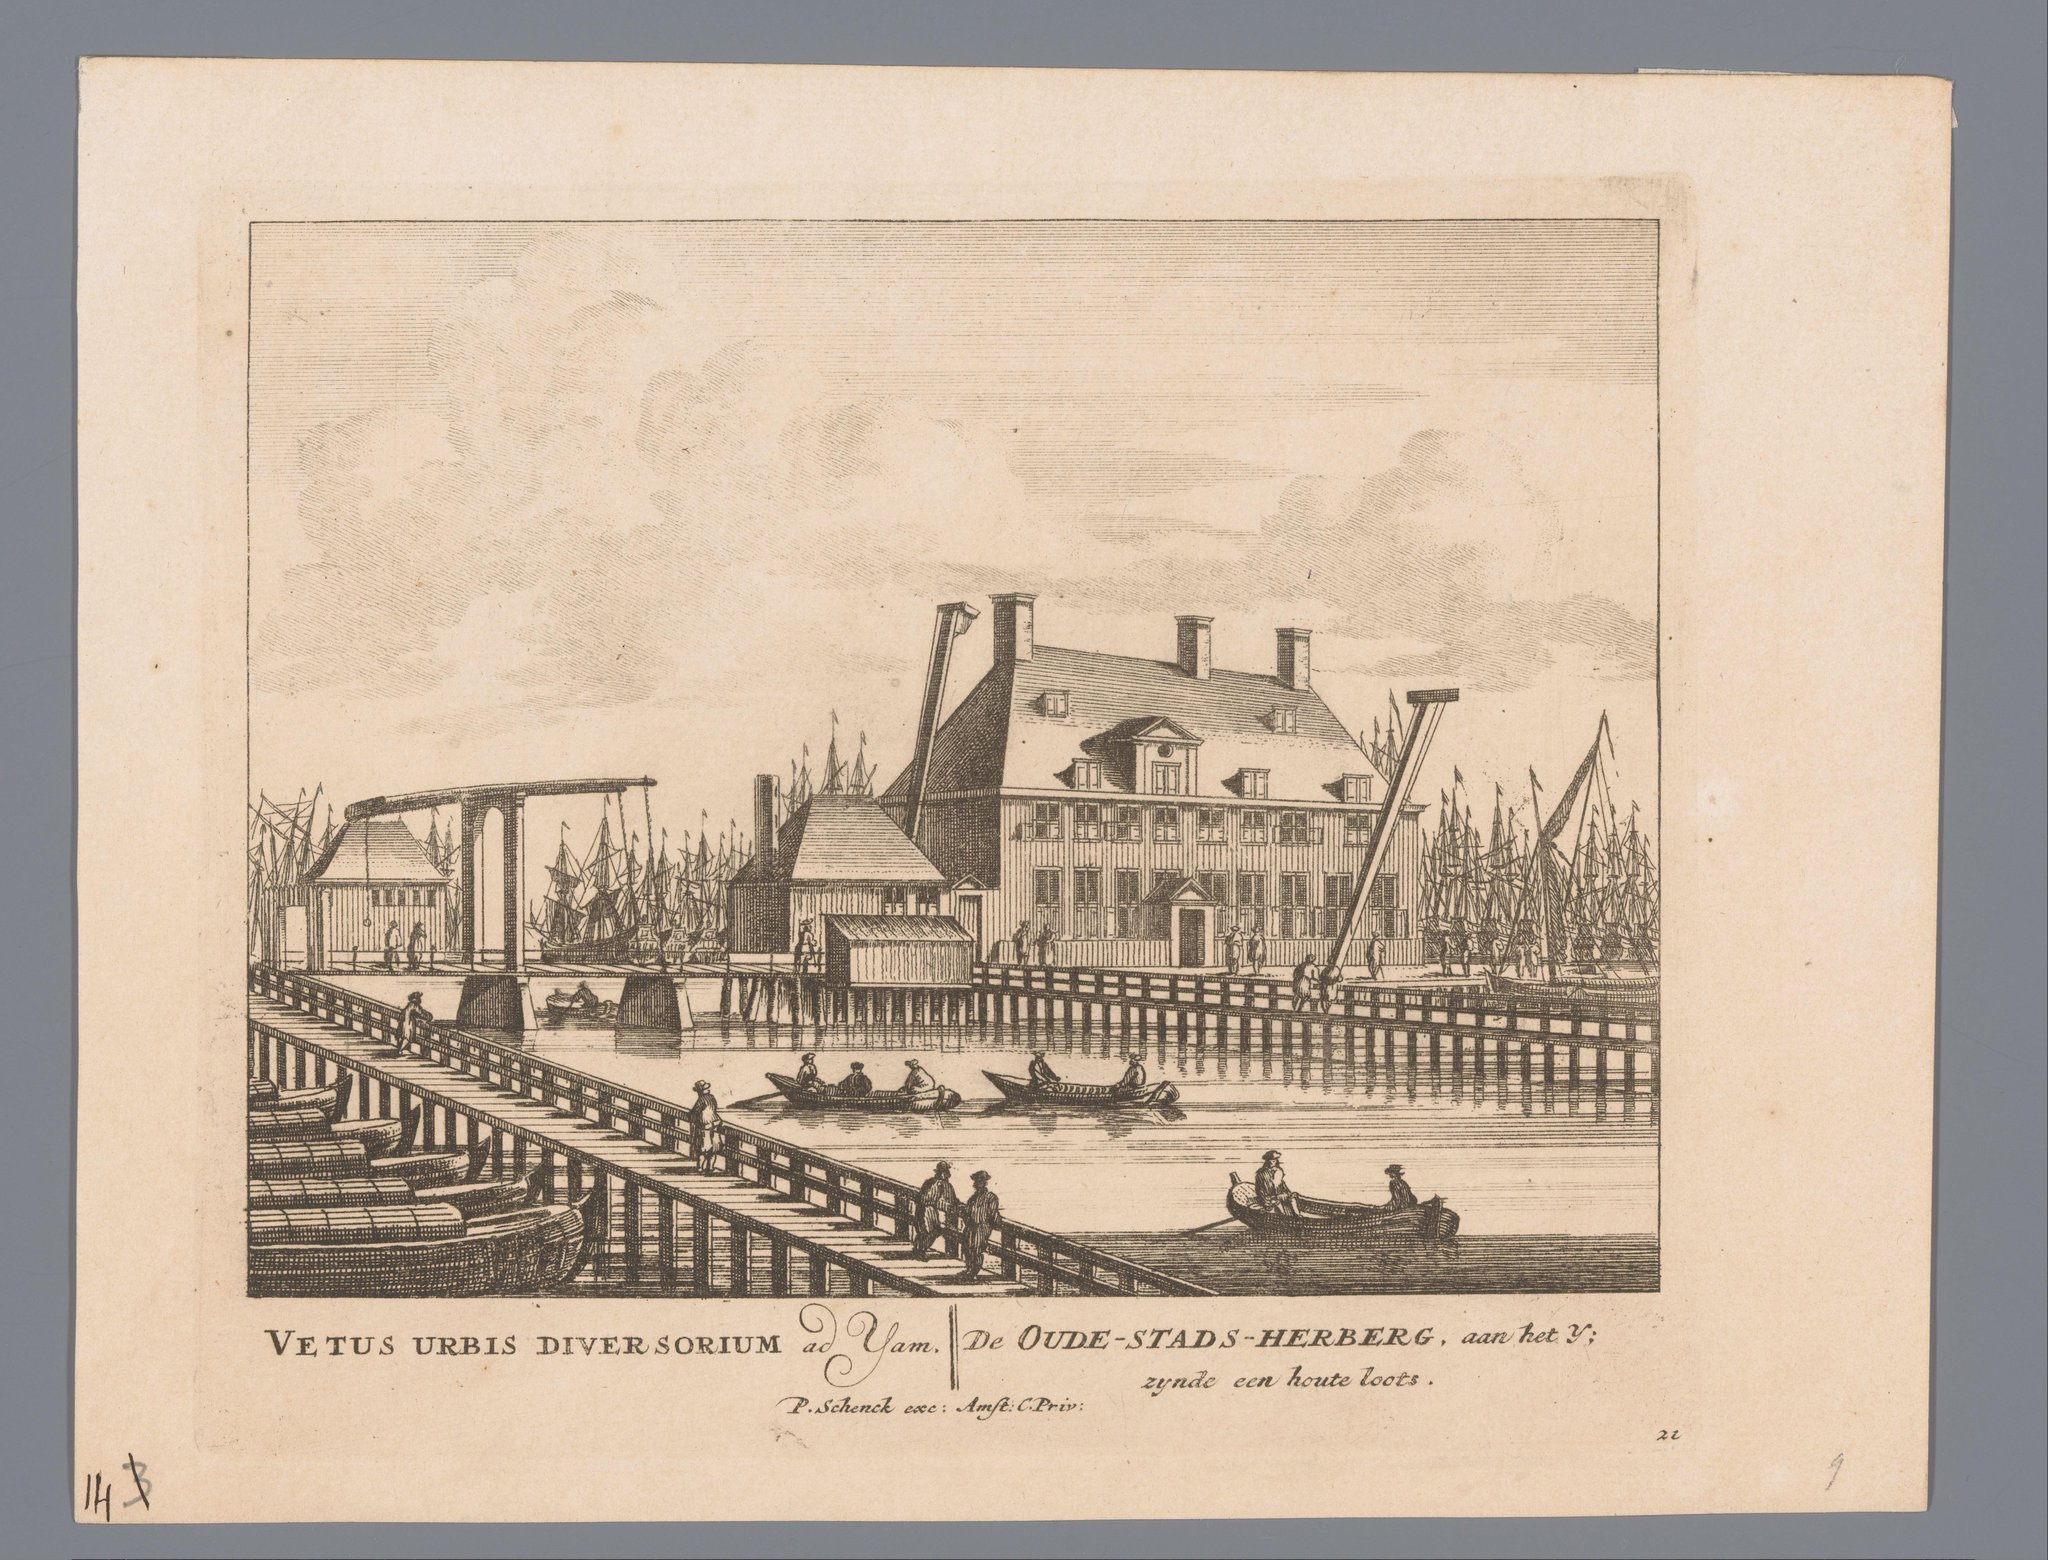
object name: print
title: 100 Afbeeldinge der voornaamste gebouwen van Amsterdam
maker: Anonymous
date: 1710-1711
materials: paper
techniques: engraving, etching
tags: sailing-ship, sailing-boat, rowing-boat, canoe, etc., bridge in city across river, canal, etc., hotel, hostelry, inn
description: Prent uit: 100 Afbeeldinge der voornaamste gebouwen van Amsterdam. Amsterdam: Pieter Schenk (I), [1710-1711]. Of: 100 Afbeeldinge der voornaamste gebouwen van Amsterdam. Amsterdam: Barent Greve, [1757-1766], prent nummer 21. In de tweede uitgave, uitgegeven door Barent Greve, is alleen de titelprent aangepast. De overige prenten zijn onveranderd gebleven.